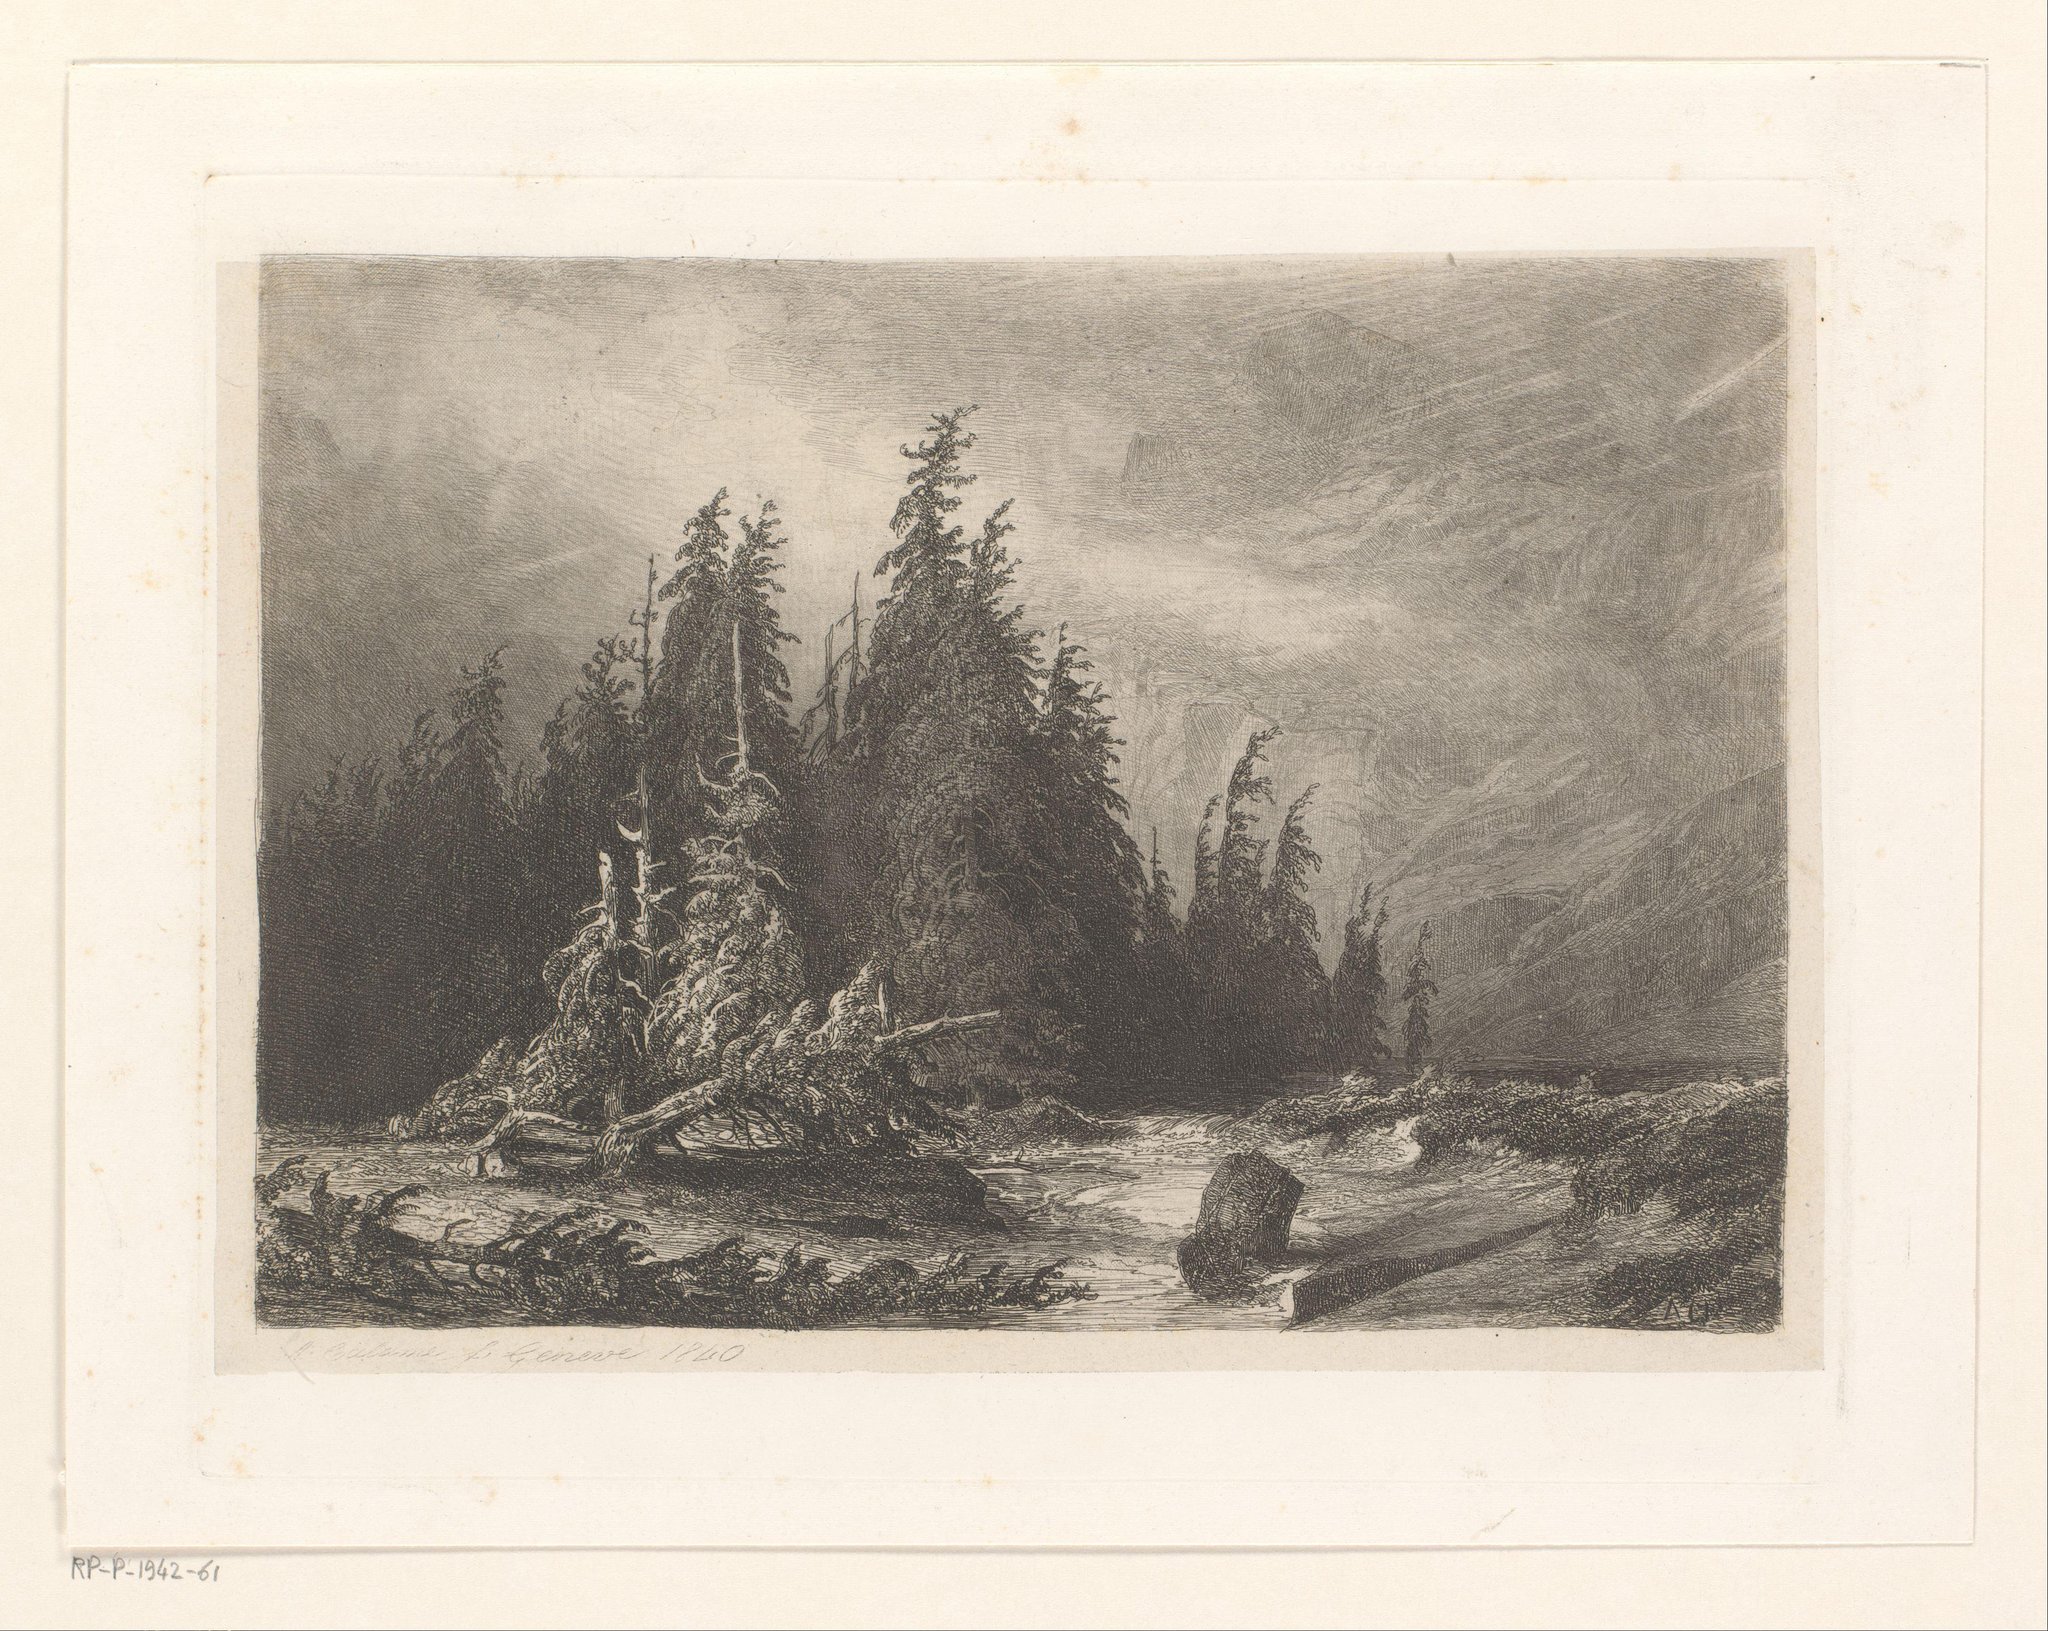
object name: print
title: Alpenlandschap met dennenbomen aan het water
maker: alexandre calame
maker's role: draughtsman, painter, print maker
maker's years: 1810-1864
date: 1840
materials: paper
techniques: etching, roulette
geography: geneva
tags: river, trees: pine, mountains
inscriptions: collector's mark: Lugt 2760, collector's mark: Lugt 2228